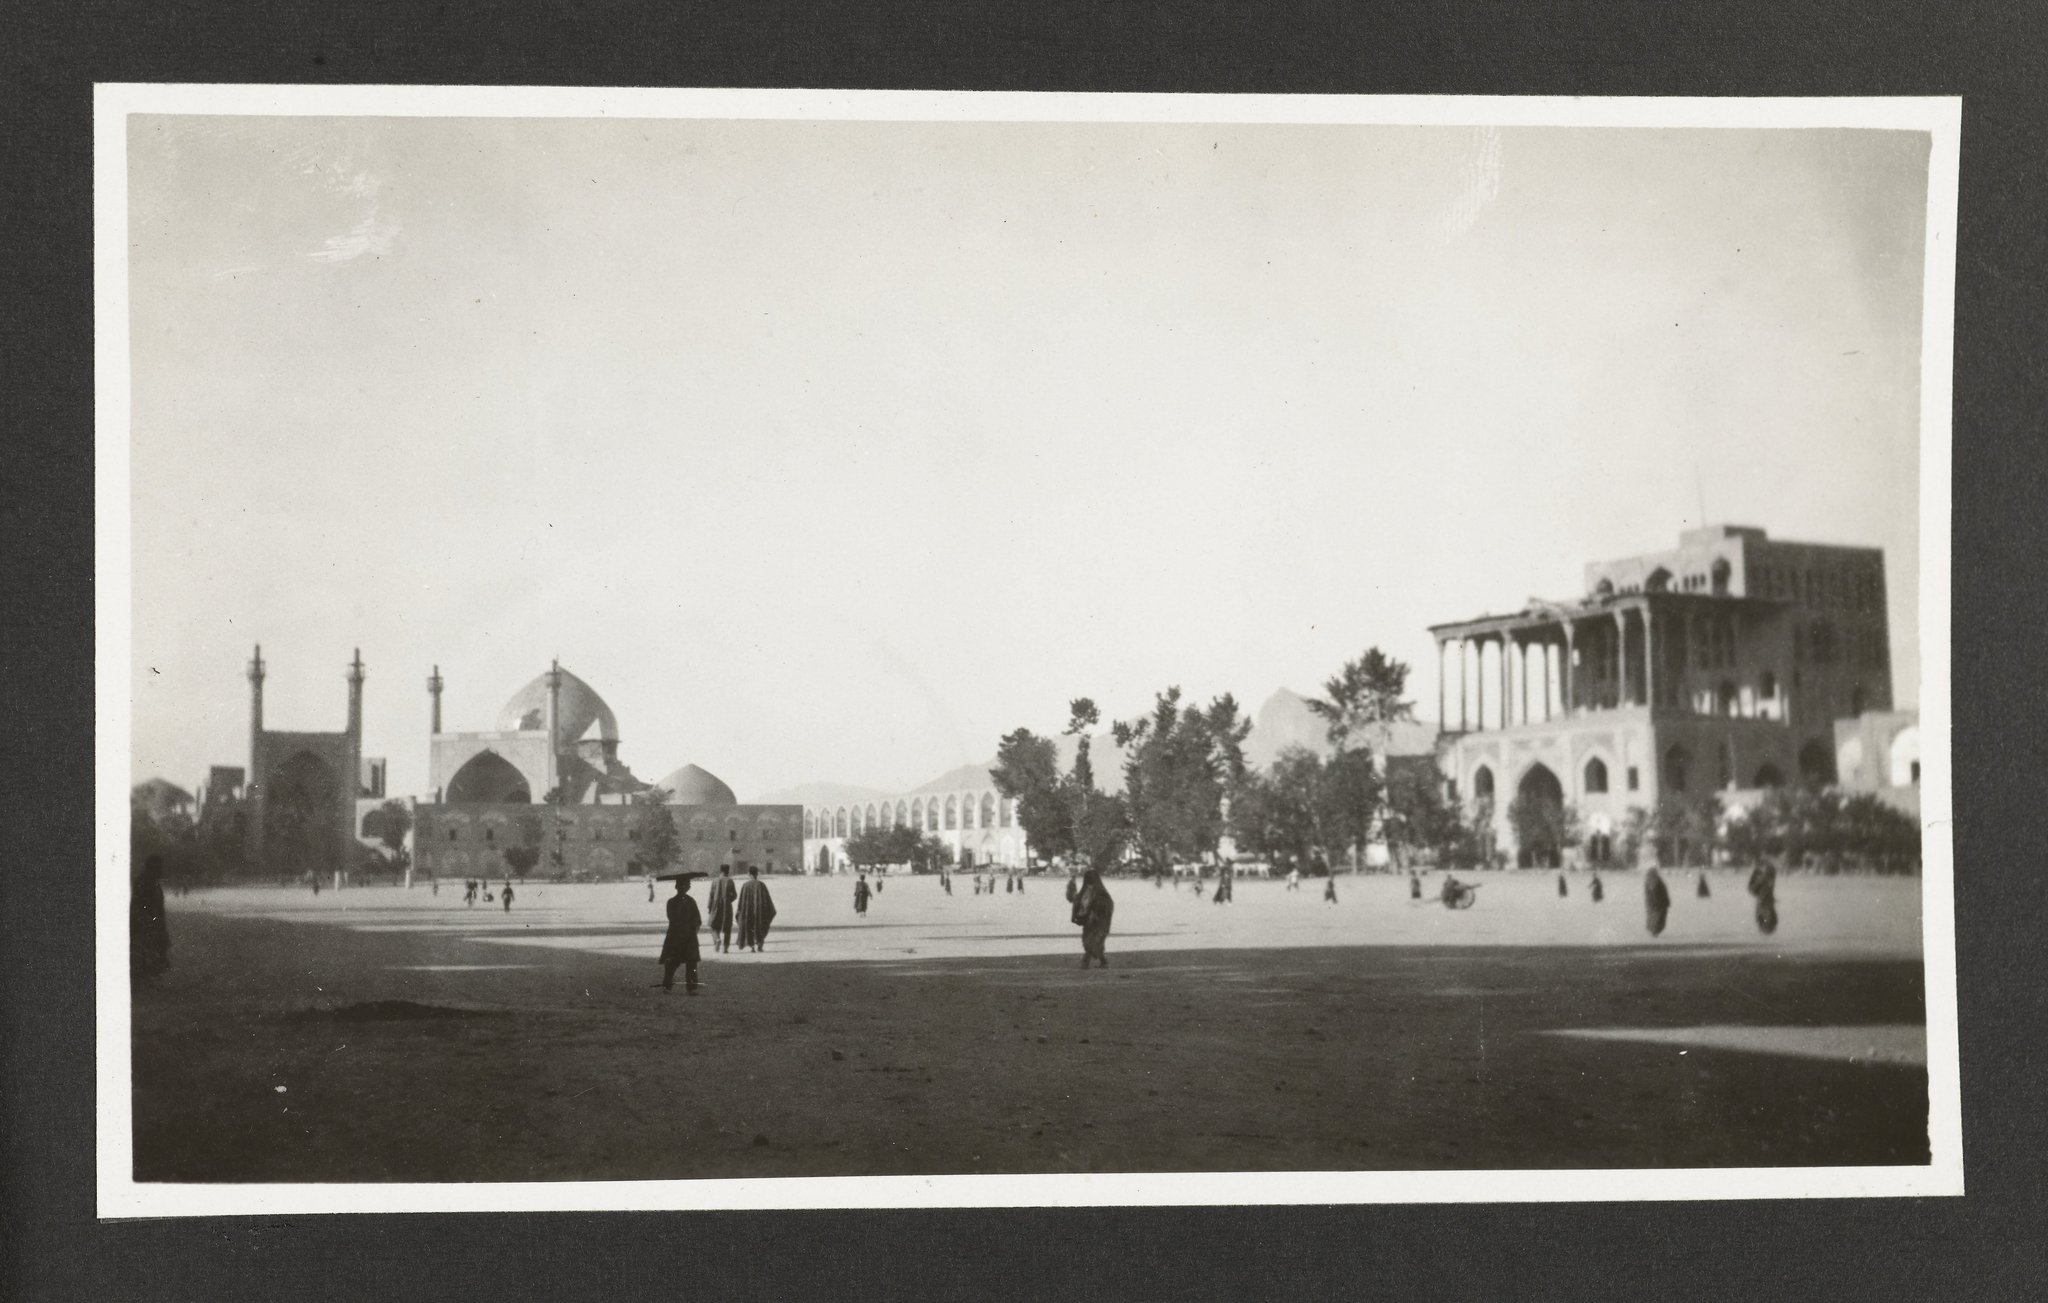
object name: photograph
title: Het Maidan Shah (Koningsplein), met links de Moskee en rechts het paleis, van waar de Shah Abas de Groote (1585-1628) de feestelykheden op het plein aanschouwde.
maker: a.g.a. van eelde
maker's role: engineer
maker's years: 1862-1950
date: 1925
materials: cardboard, paper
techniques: gelatin silver print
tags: isfahan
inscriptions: number: ‘21.’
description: Titel op object afkomstig uit inventaris (Verklaring der Photo's) behorend bij het album.